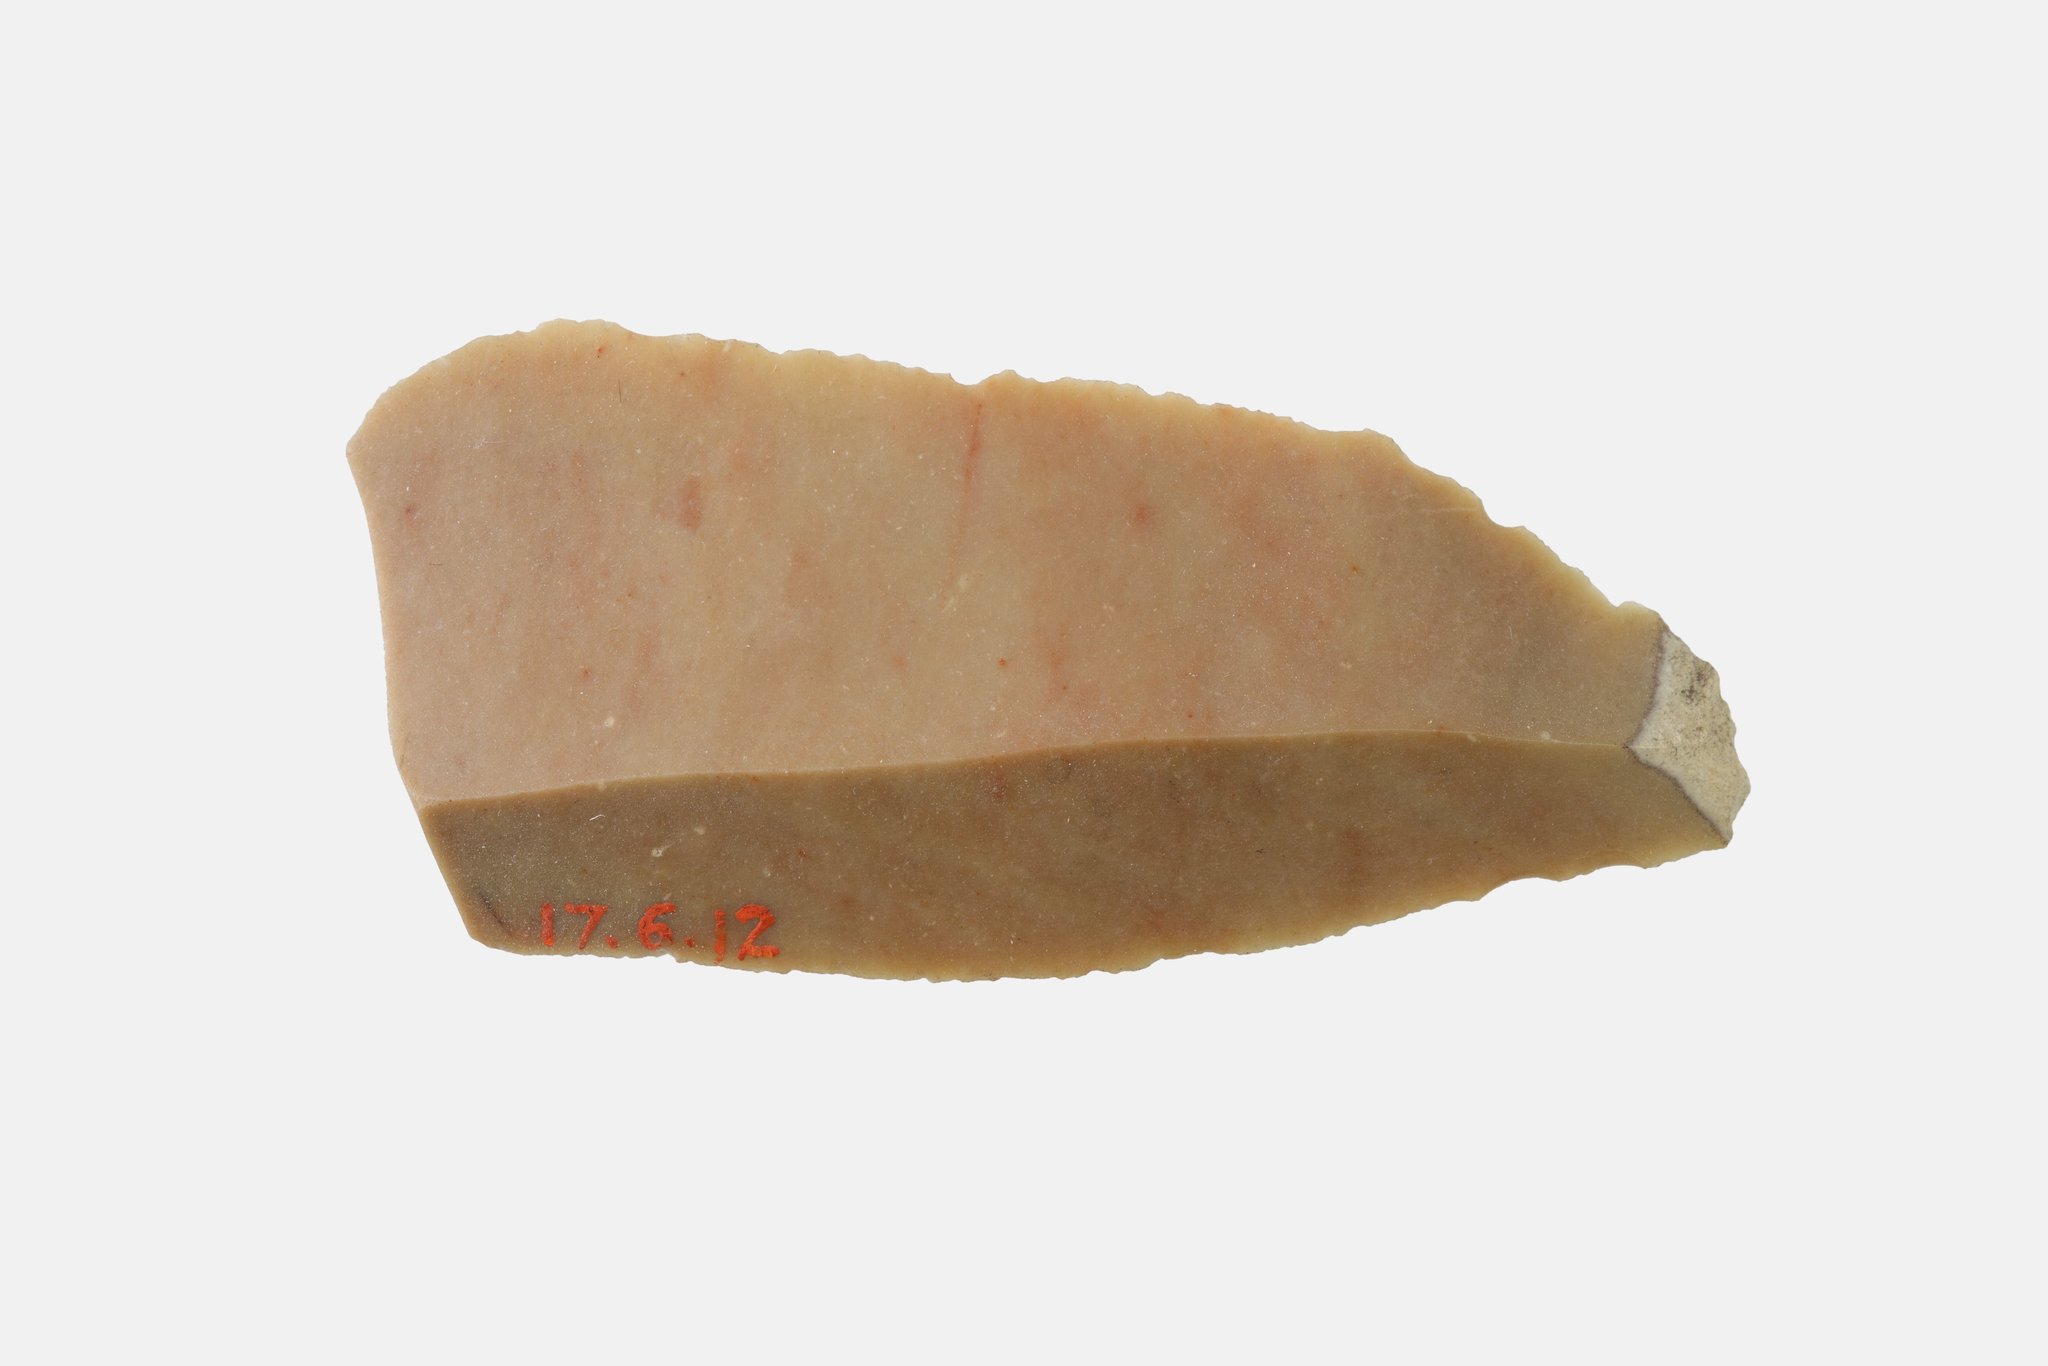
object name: knife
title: Blade Fragment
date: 3100-2650 BCE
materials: stone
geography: northern upper egypt